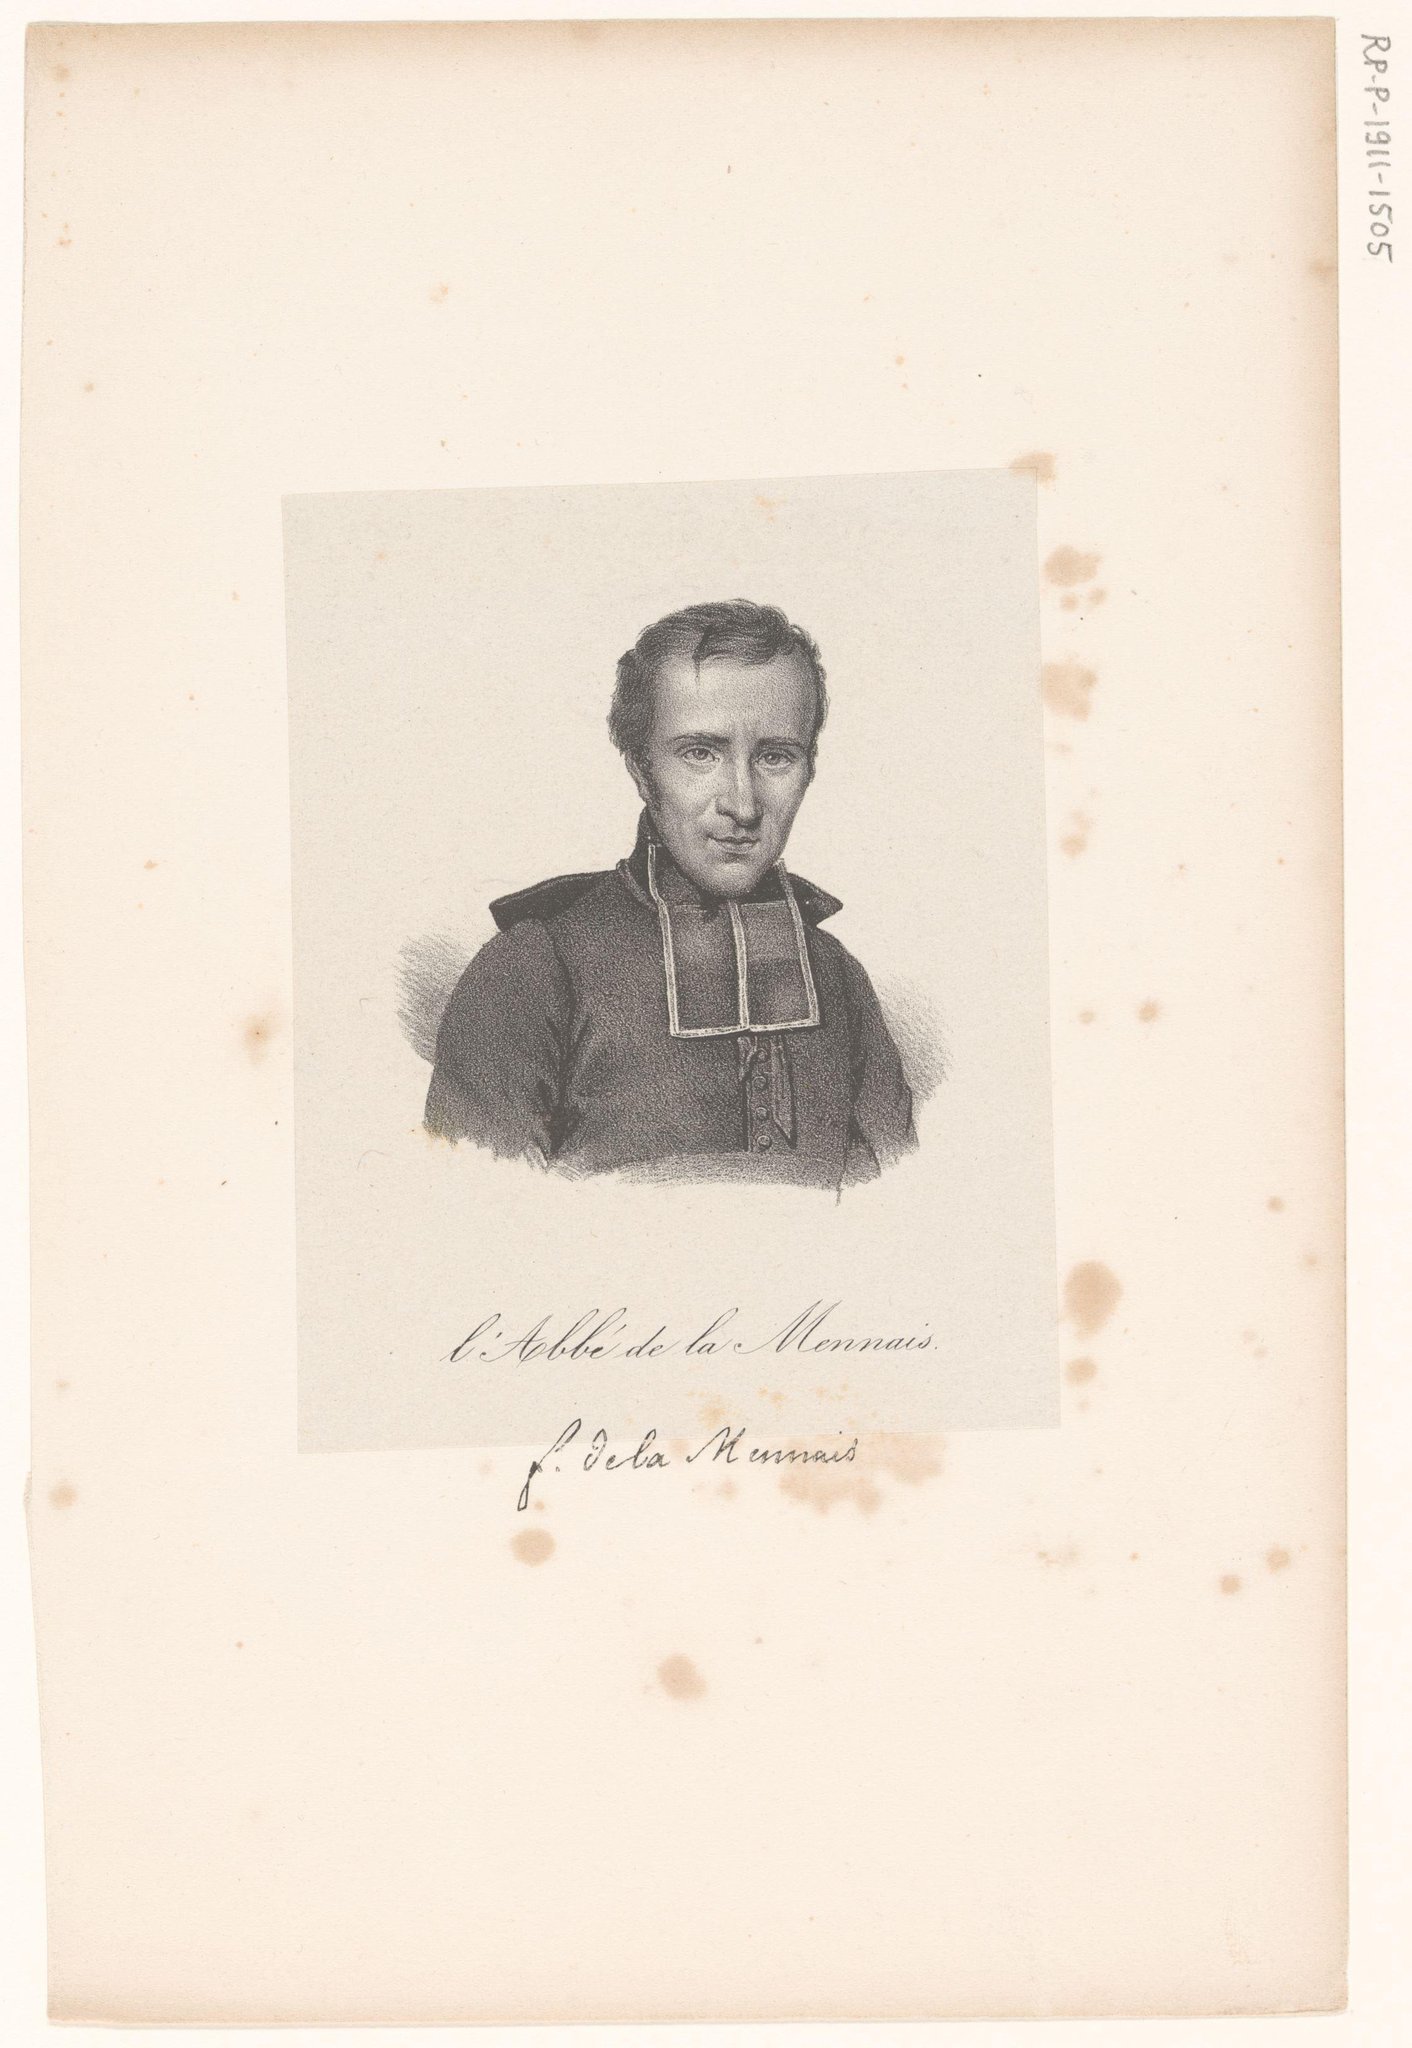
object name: print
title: Portret van Maria Louise van Savoye, Prinses de Lamballe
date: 1818-1842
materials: paper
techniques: lithograph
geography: paris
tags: paris, historical persons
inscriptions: collector's mark: Lugt 2228a